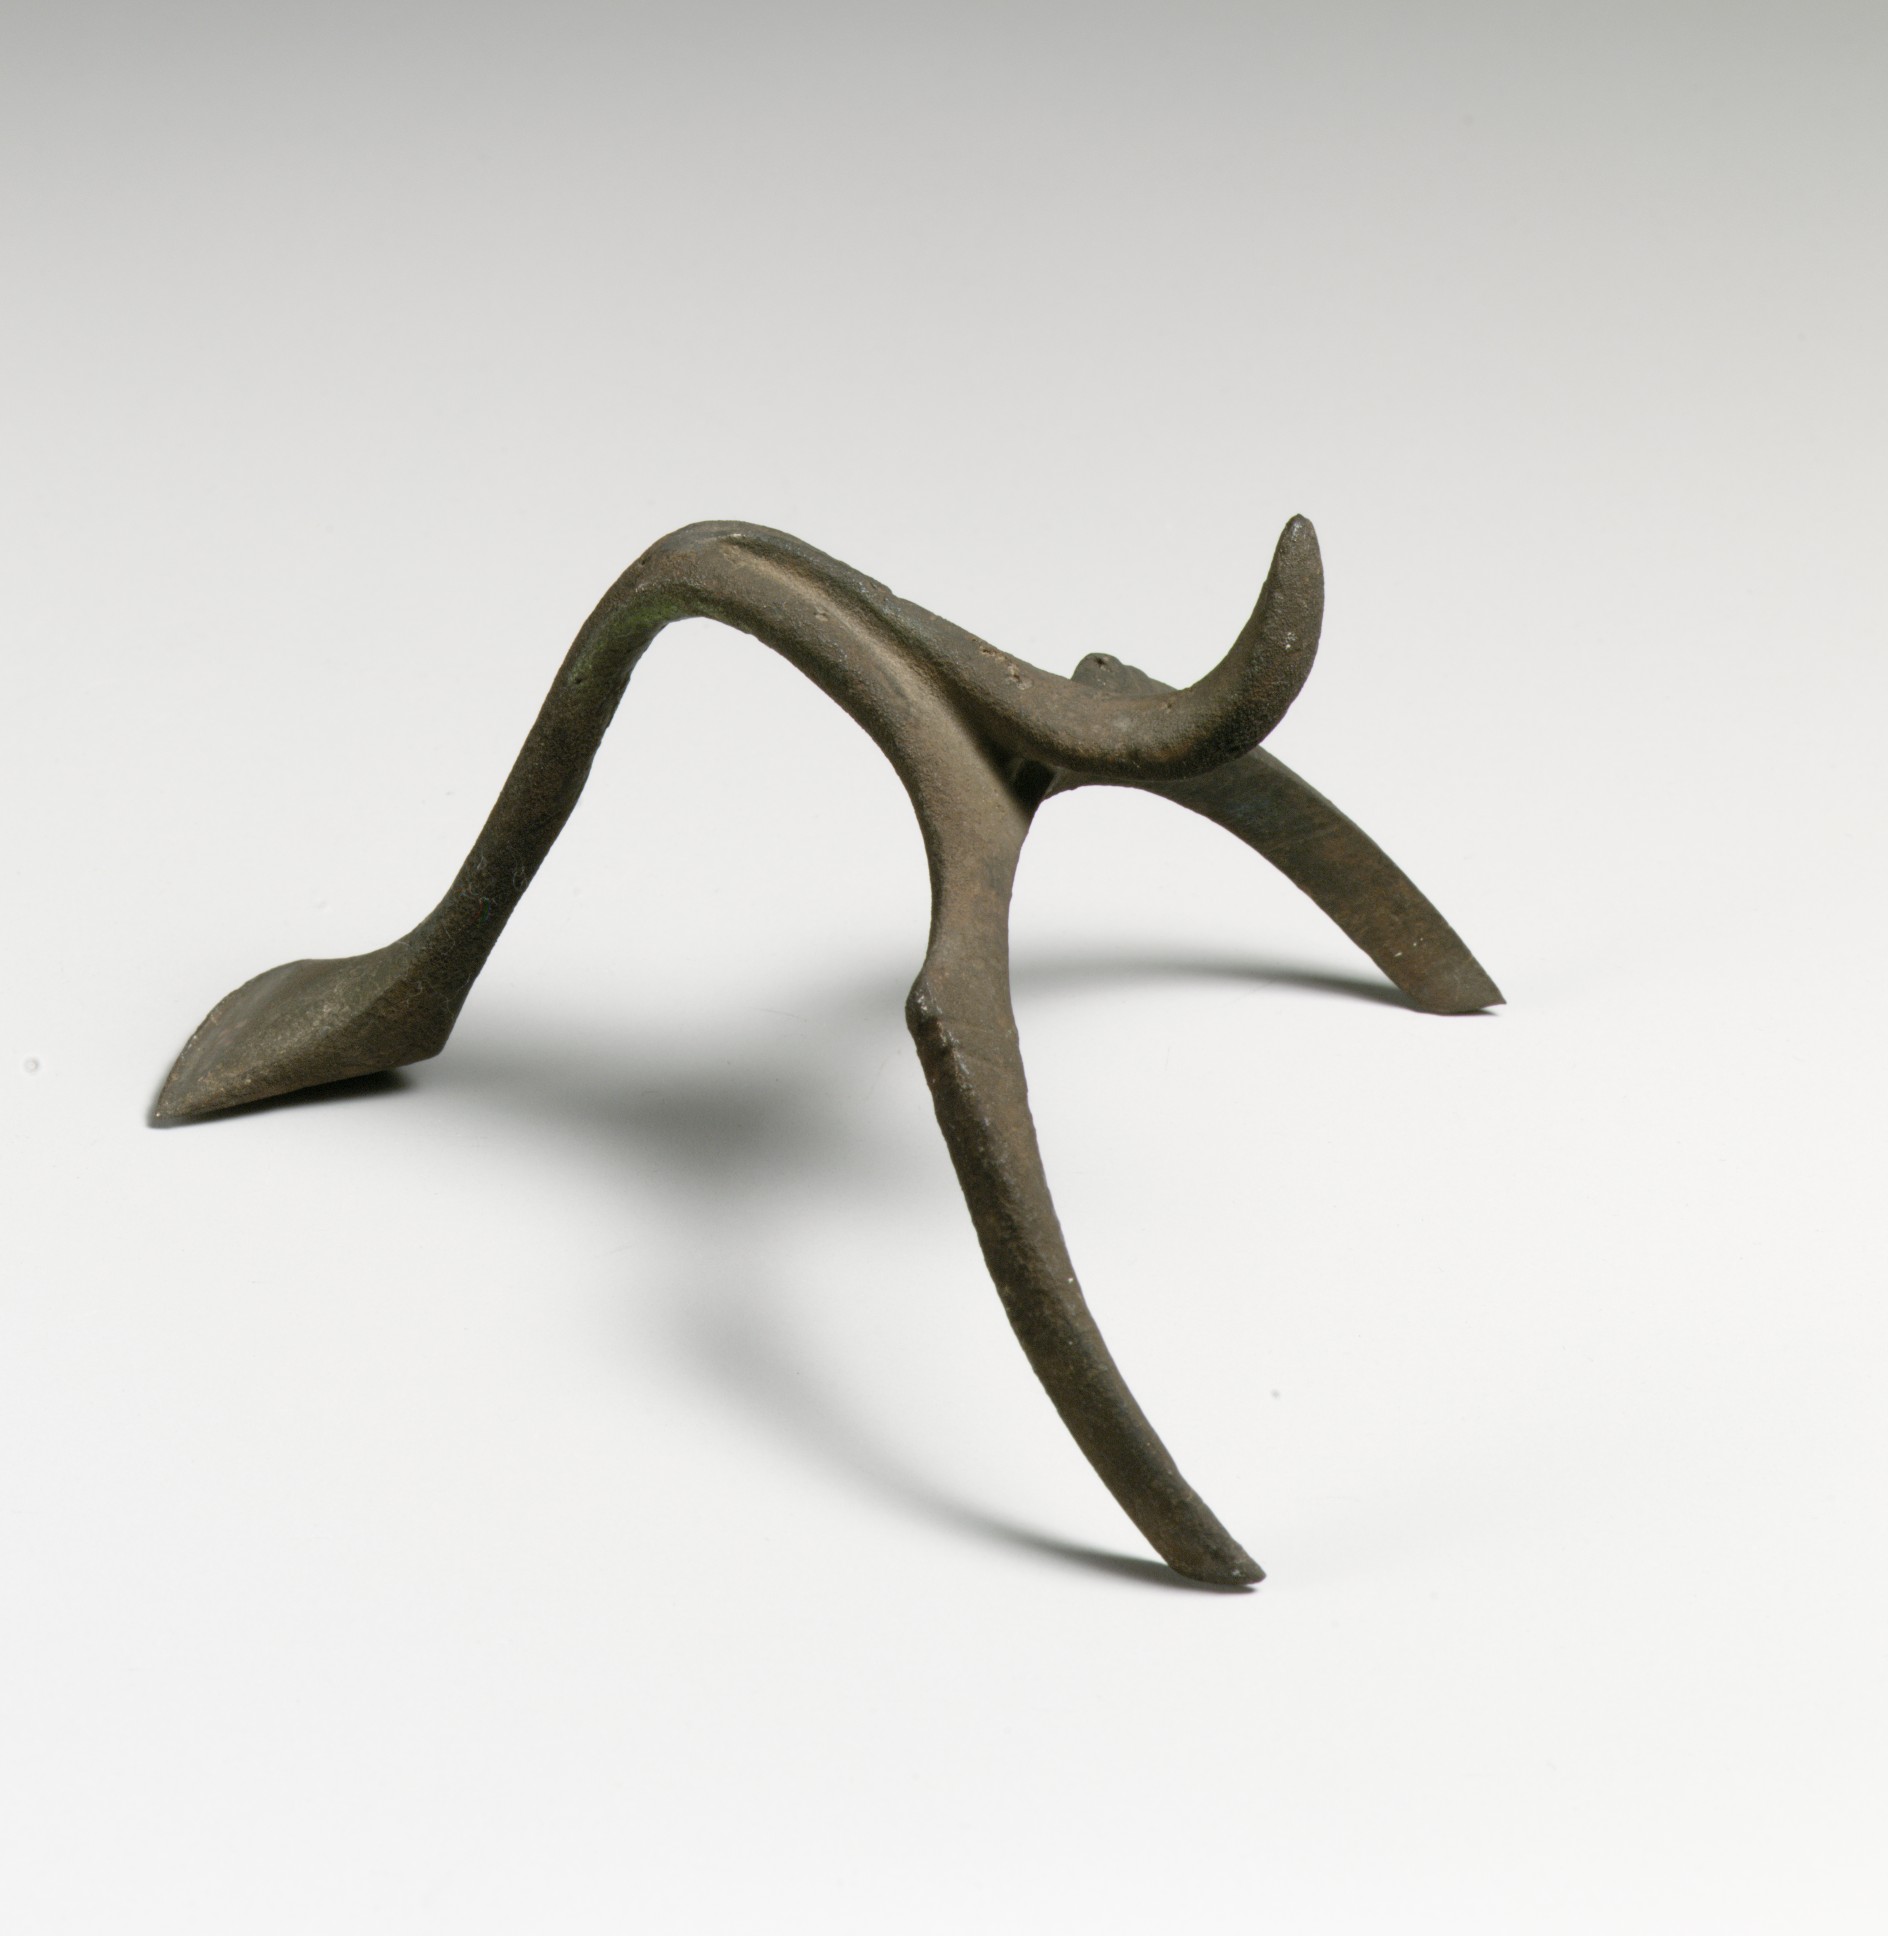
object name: handle of a jug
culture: cypriot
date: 700-501 BCE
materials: bronze